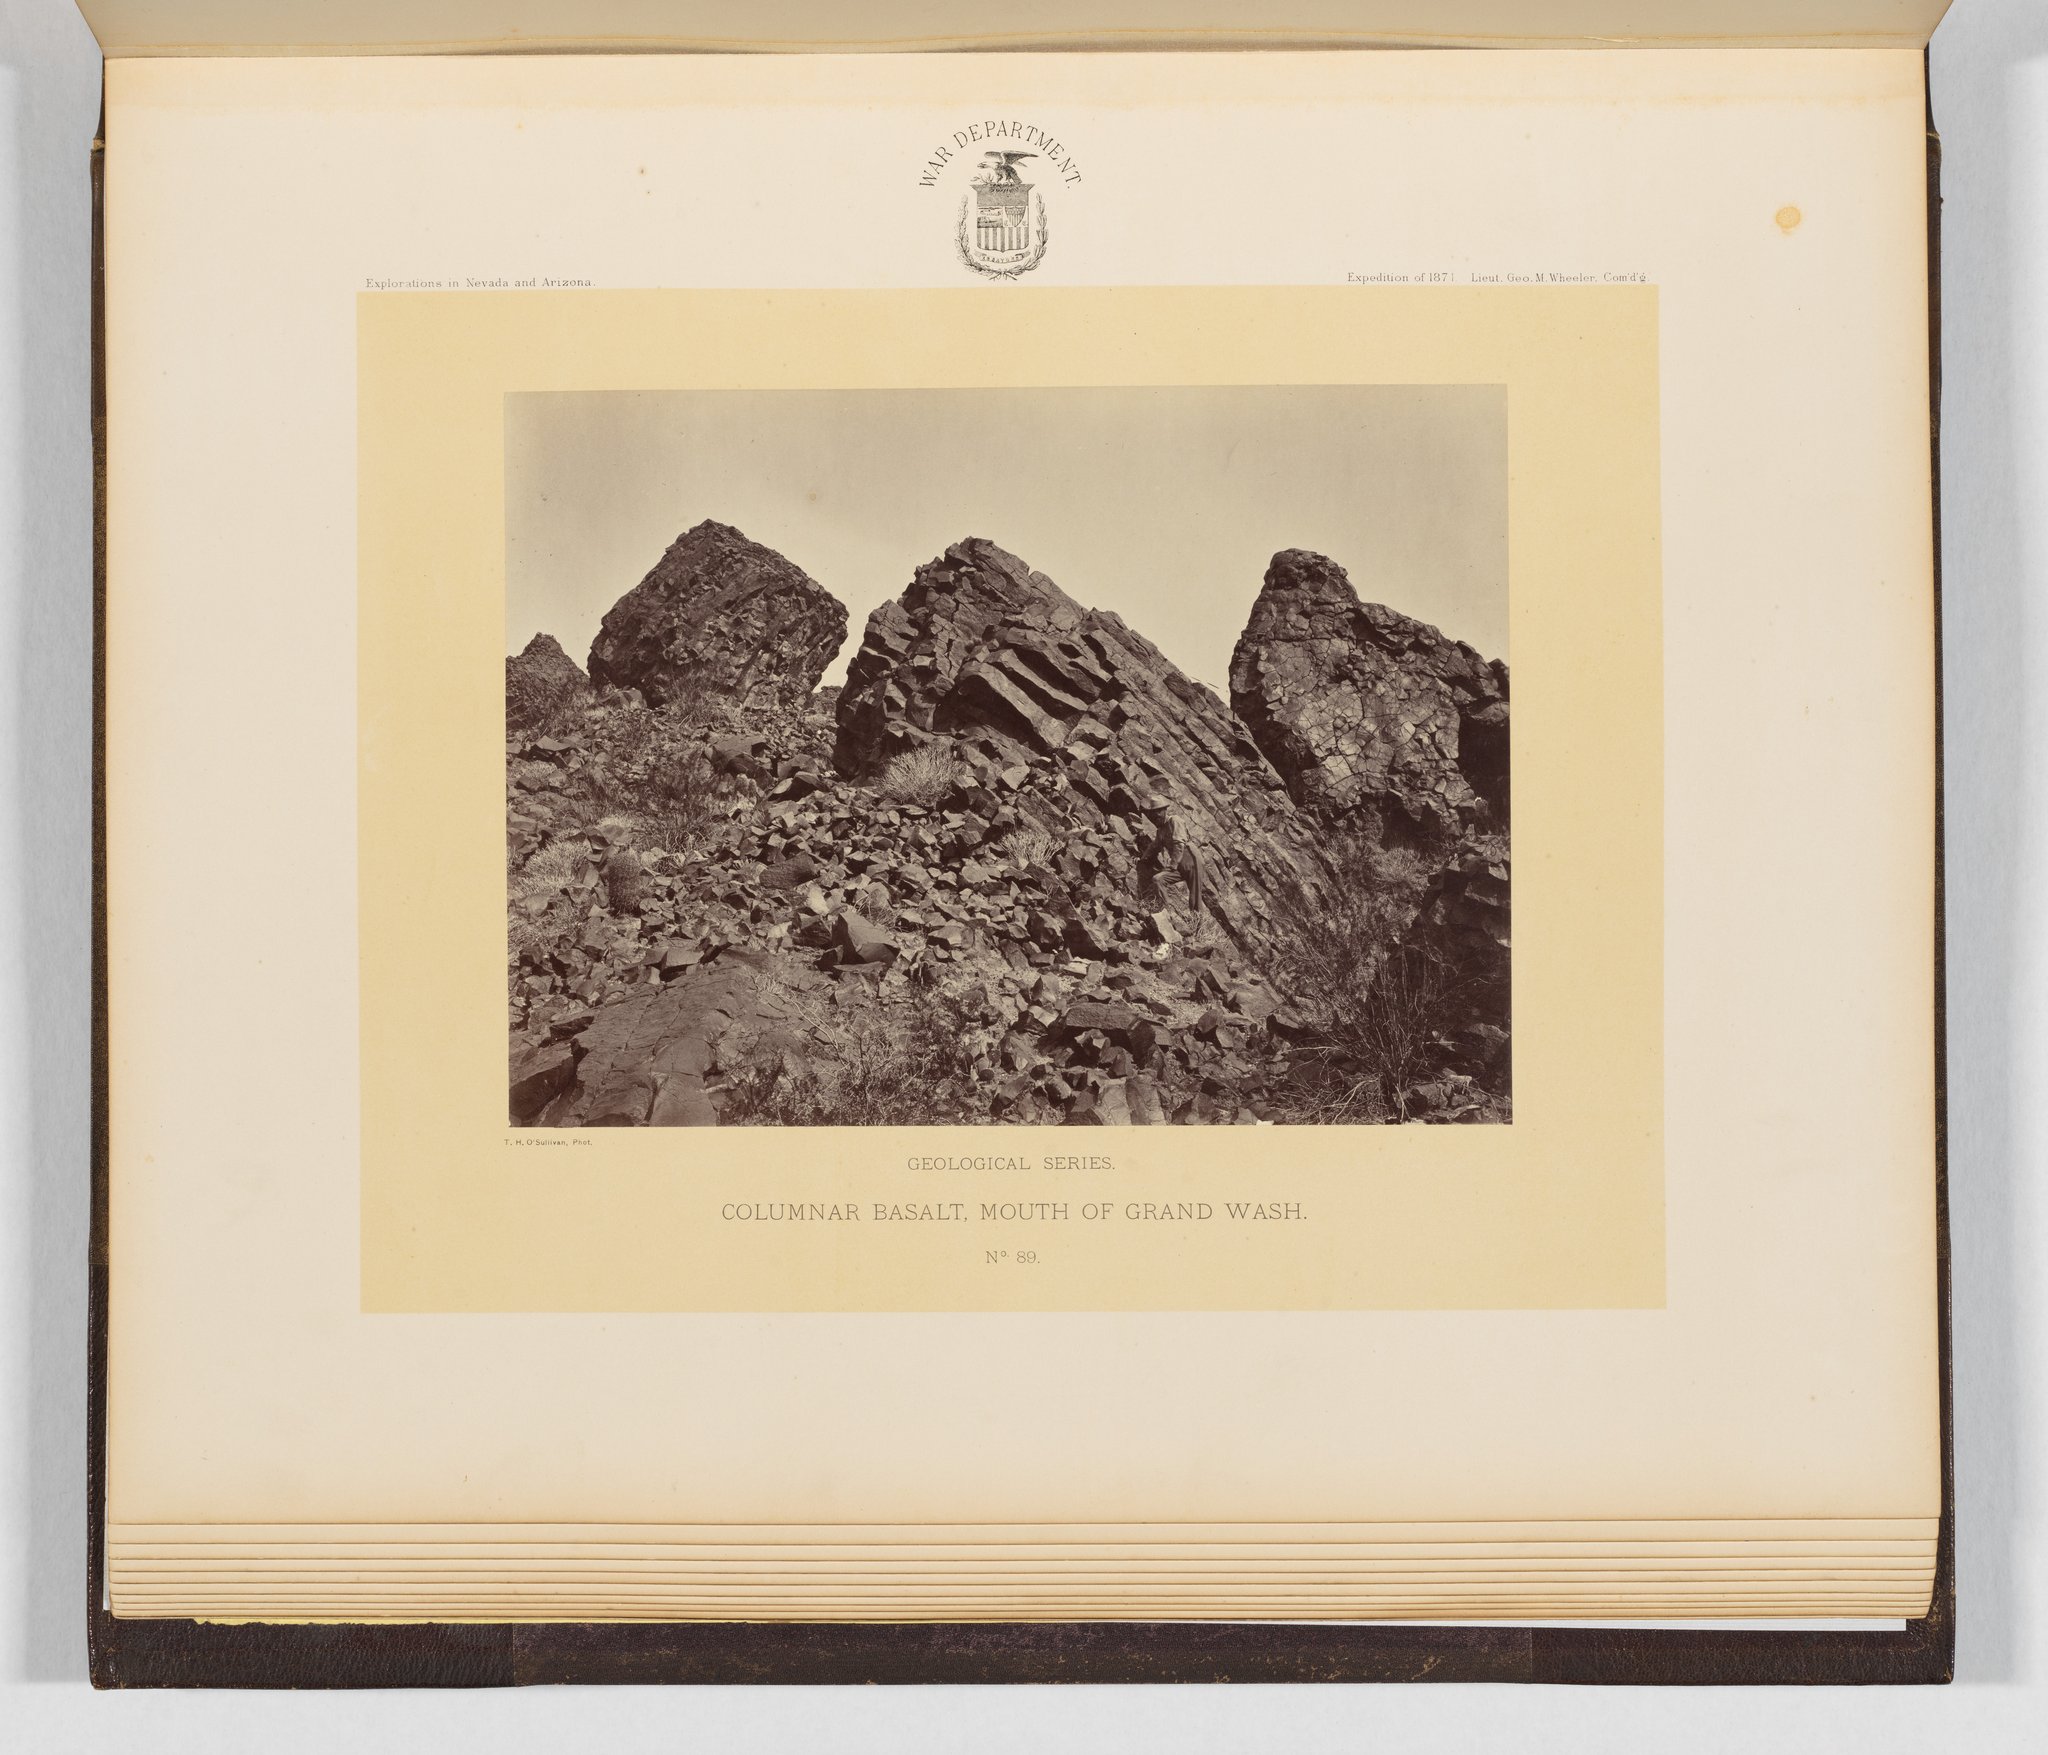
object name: photograph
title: Columnar Basalt, Mouth of Grand Wash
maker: timothy h. o'sullivan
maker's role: artist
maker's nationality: american, born ireland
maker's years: 1840-1882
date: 1871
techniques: albumen silver print, glass negative